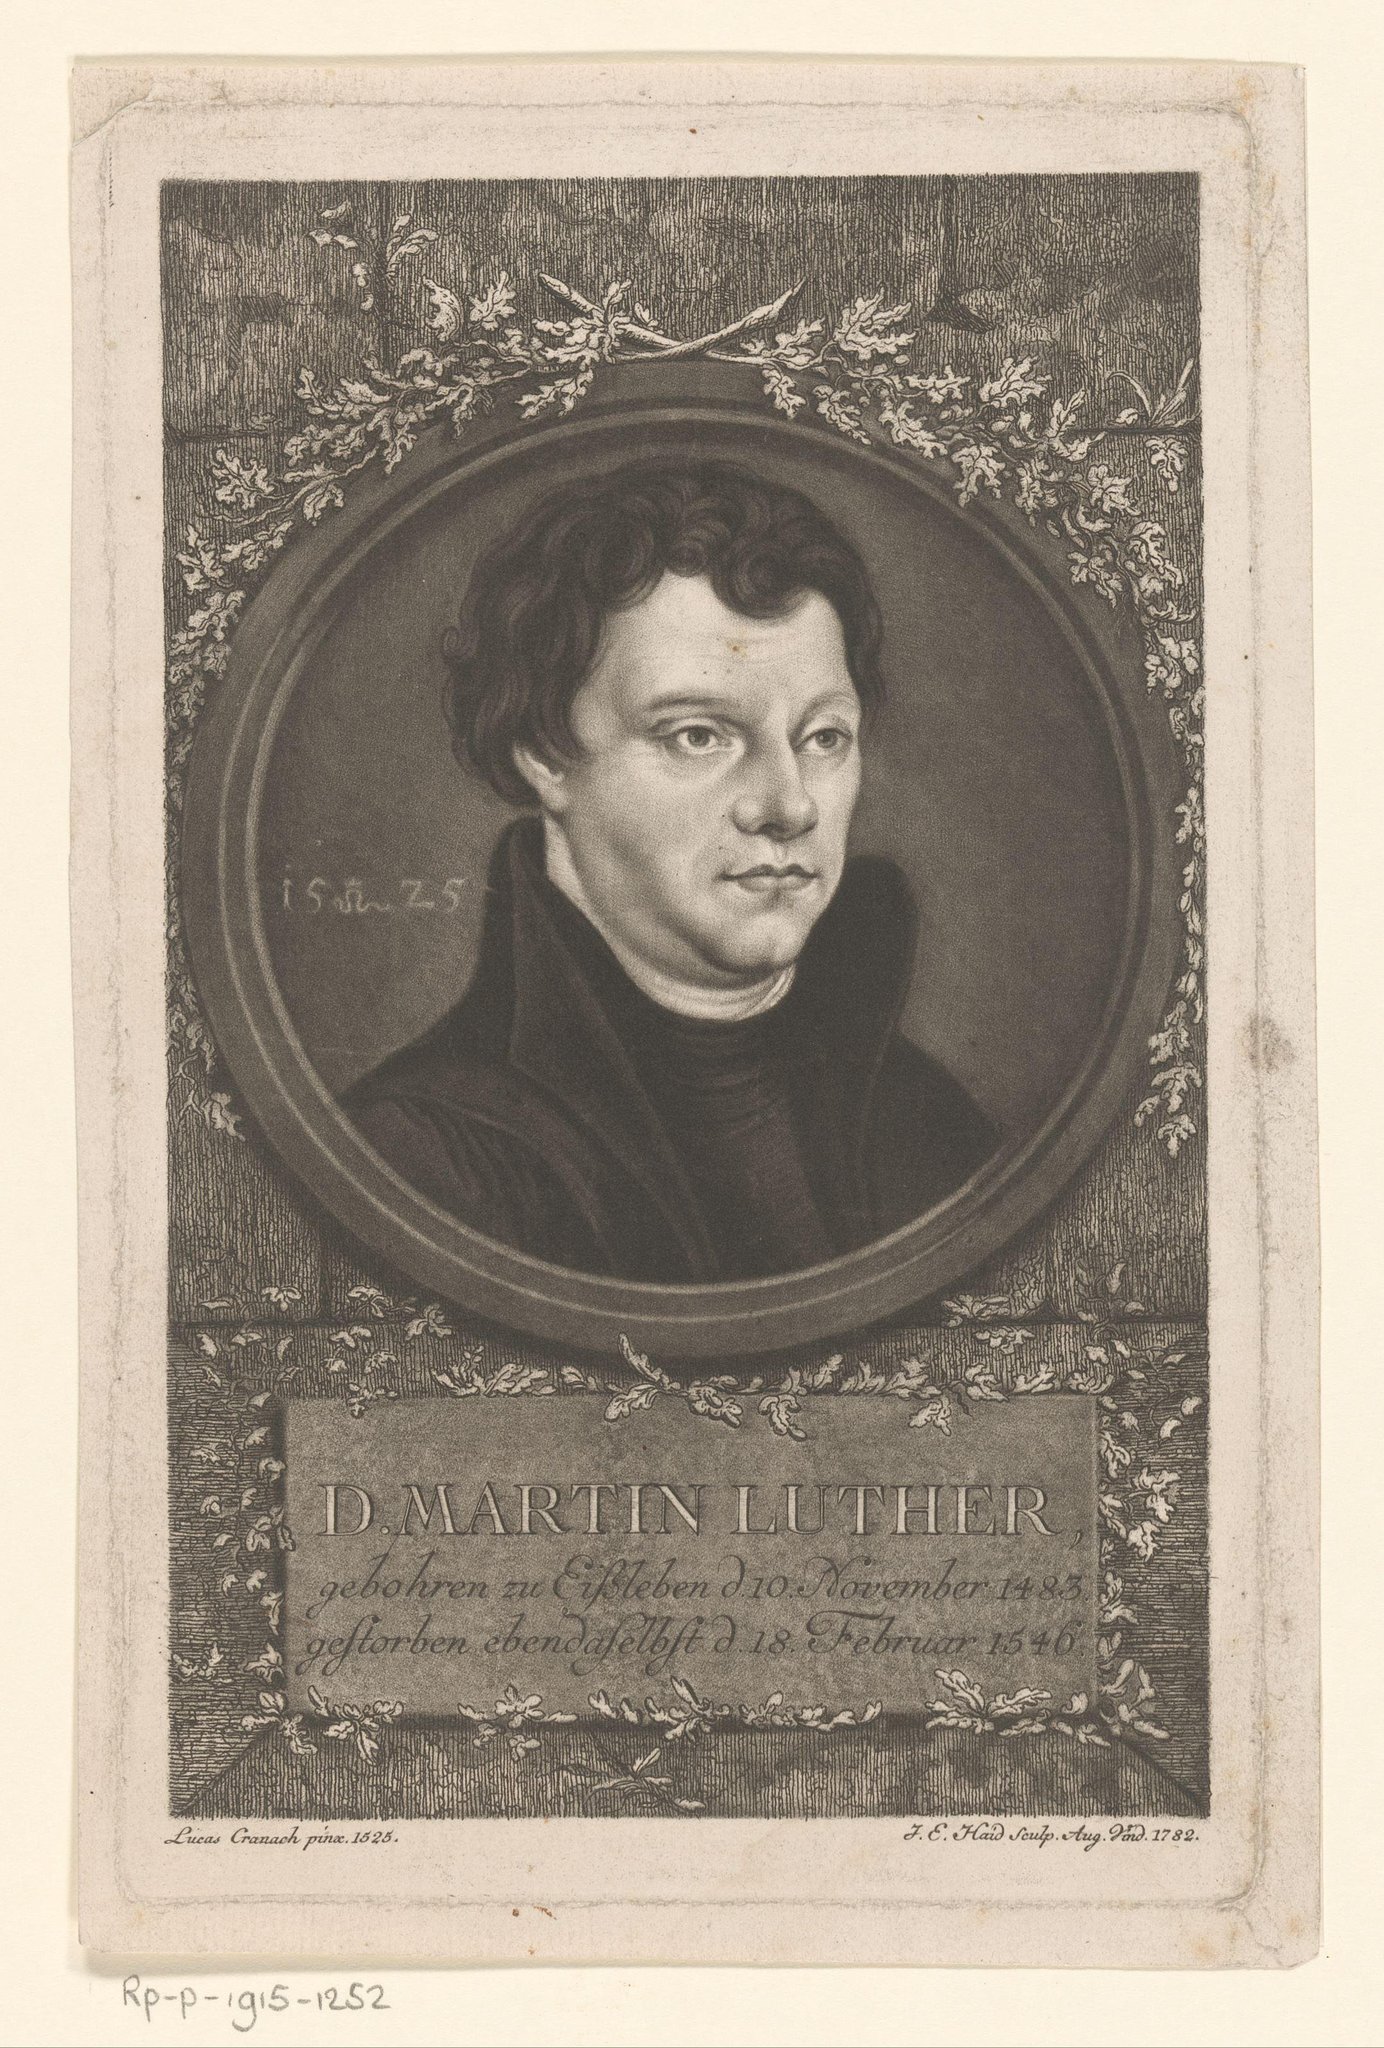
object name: print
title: Portret van Martin Luther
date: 1782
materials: paper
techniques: etching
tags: priest, martin luther, trees: laurel (branch, stick), theologian, historical persons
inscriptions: collector's mark: Lugt 2228